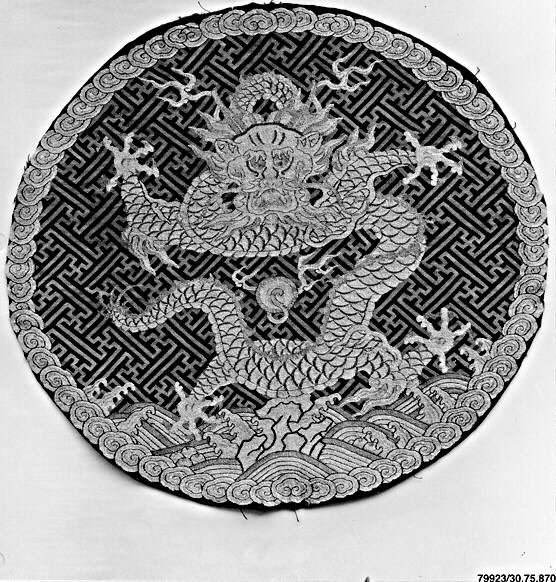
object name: medallion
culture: chinese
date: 1801-1900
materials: metal thread, silk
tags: dragons